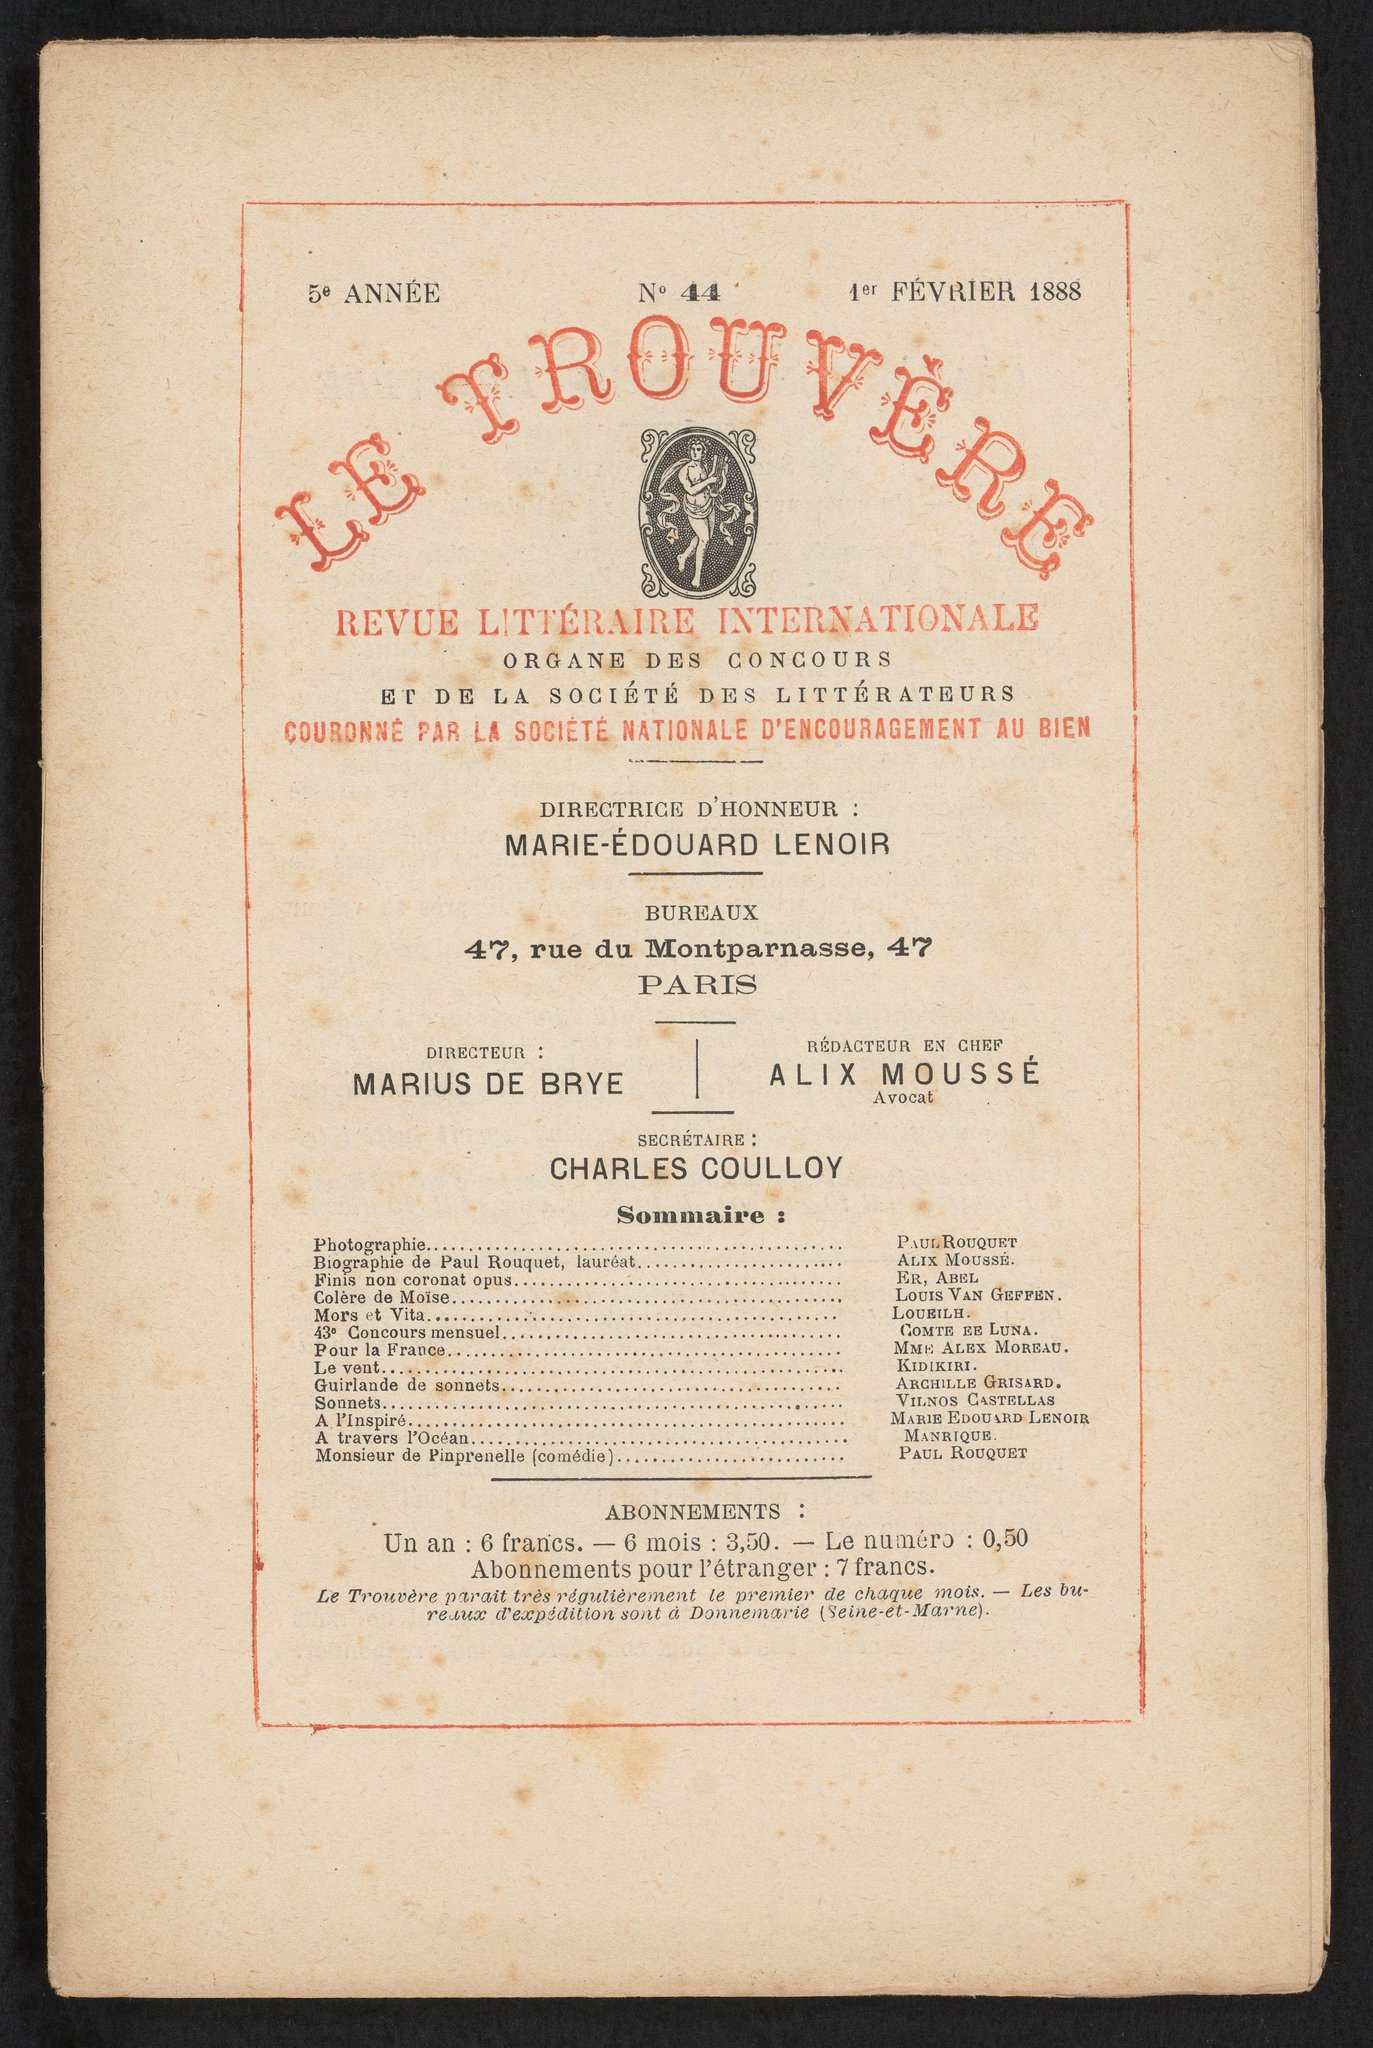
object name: book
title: Le trouvère No 44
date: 1802-1888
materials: paper, photographic support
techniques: albumen print, printing, engraving